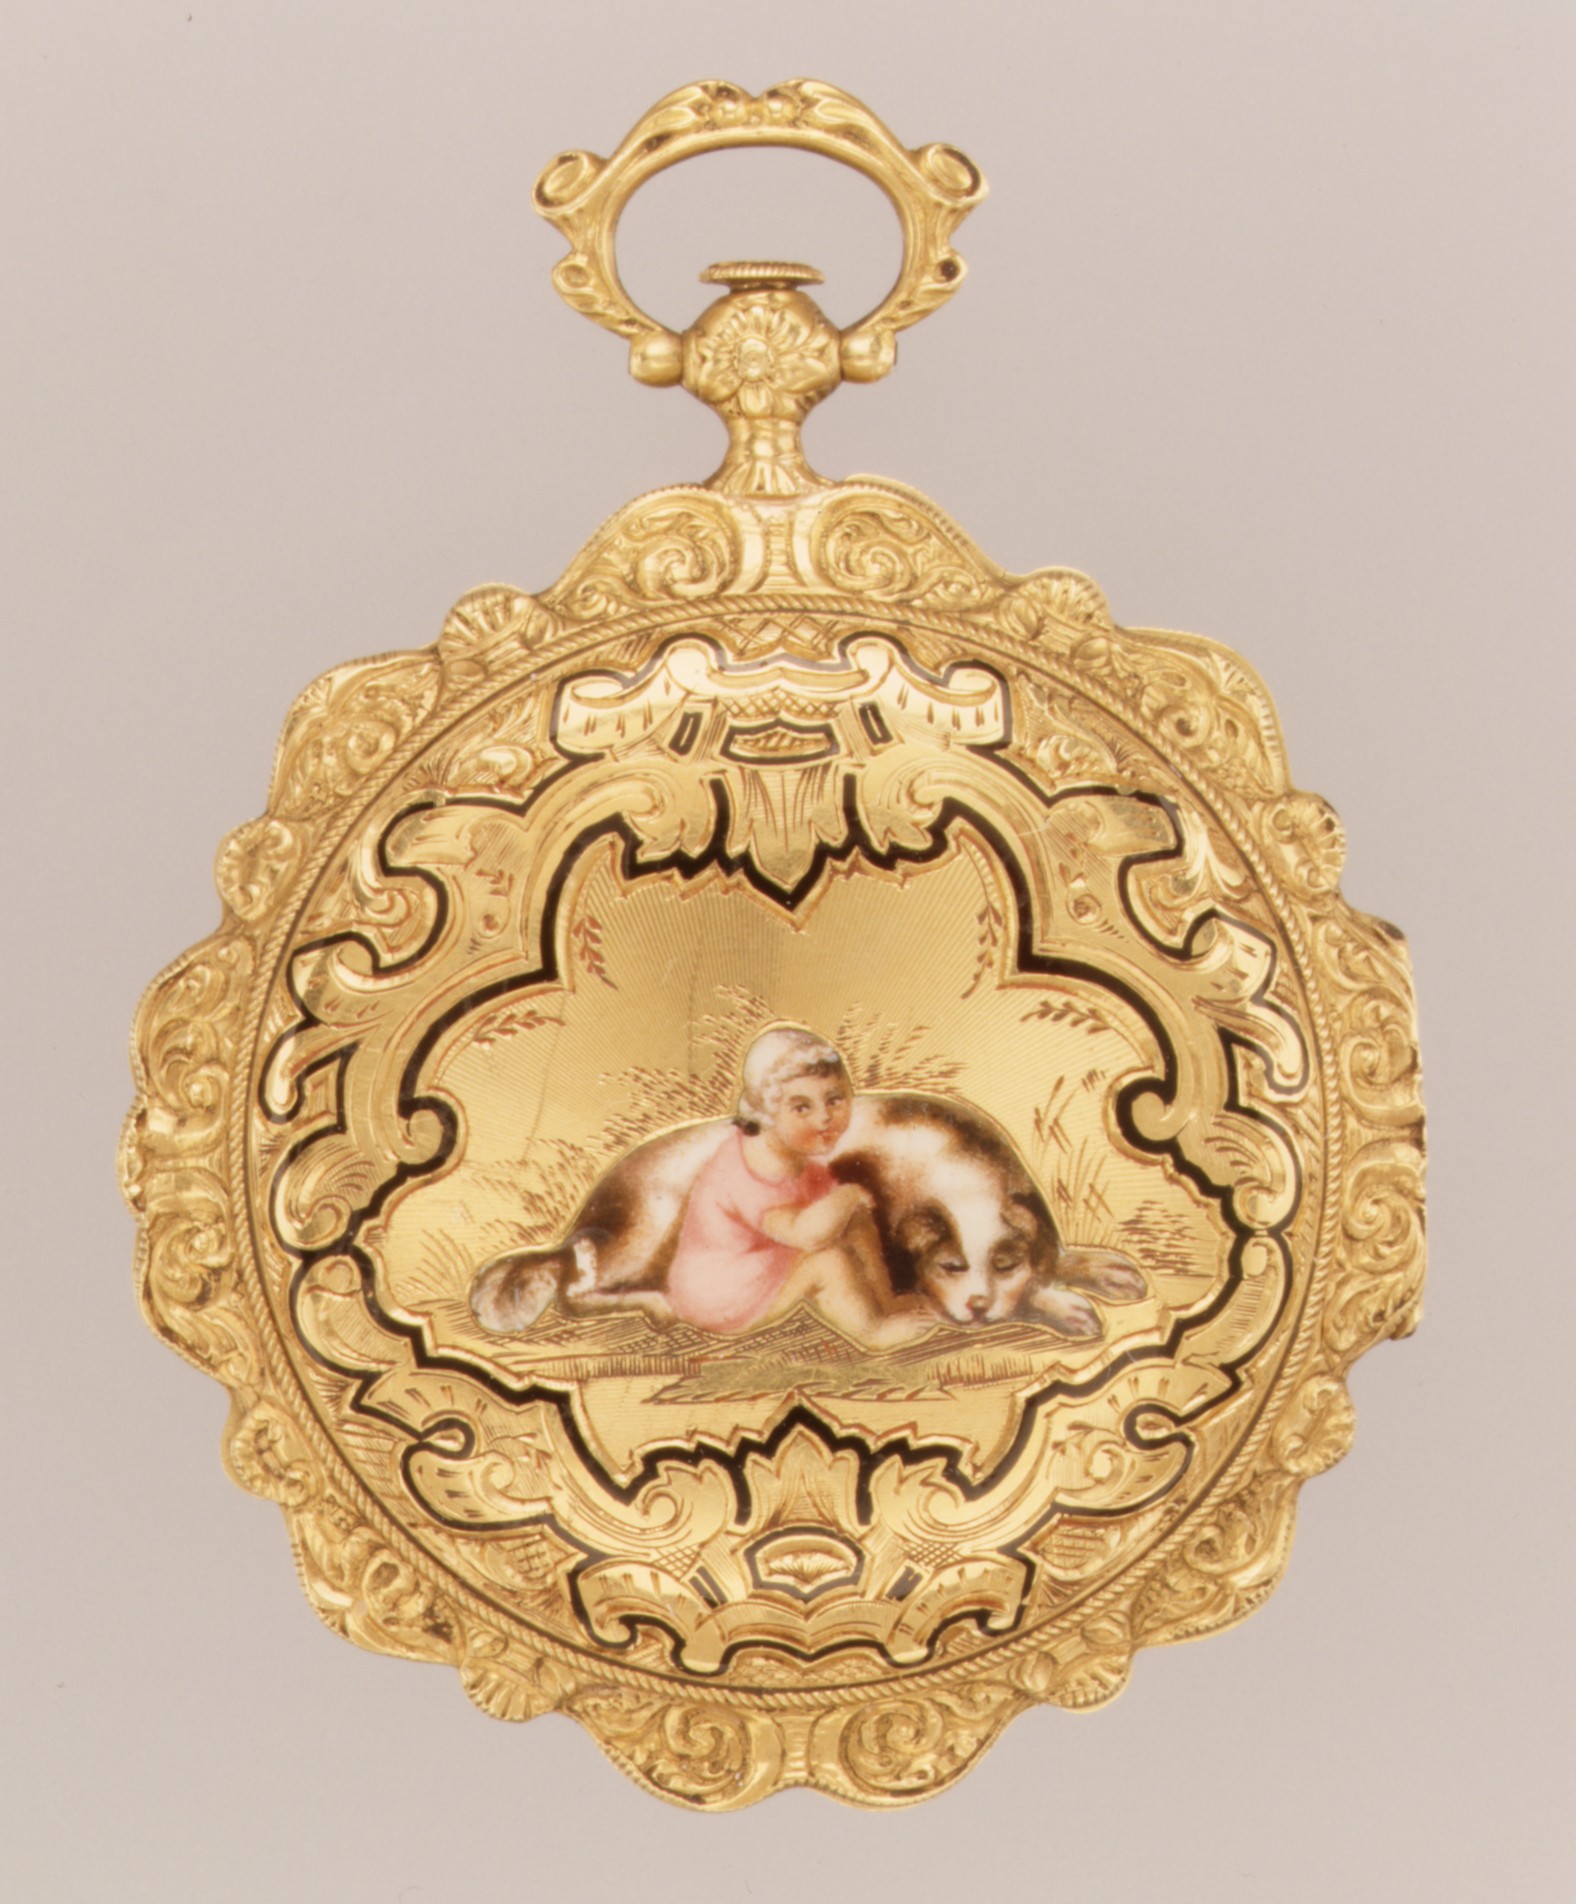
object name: watch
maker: de choudens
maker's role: maker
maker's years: 1828-1831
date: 1835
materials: enamel, gold, silver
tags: girls,dogs